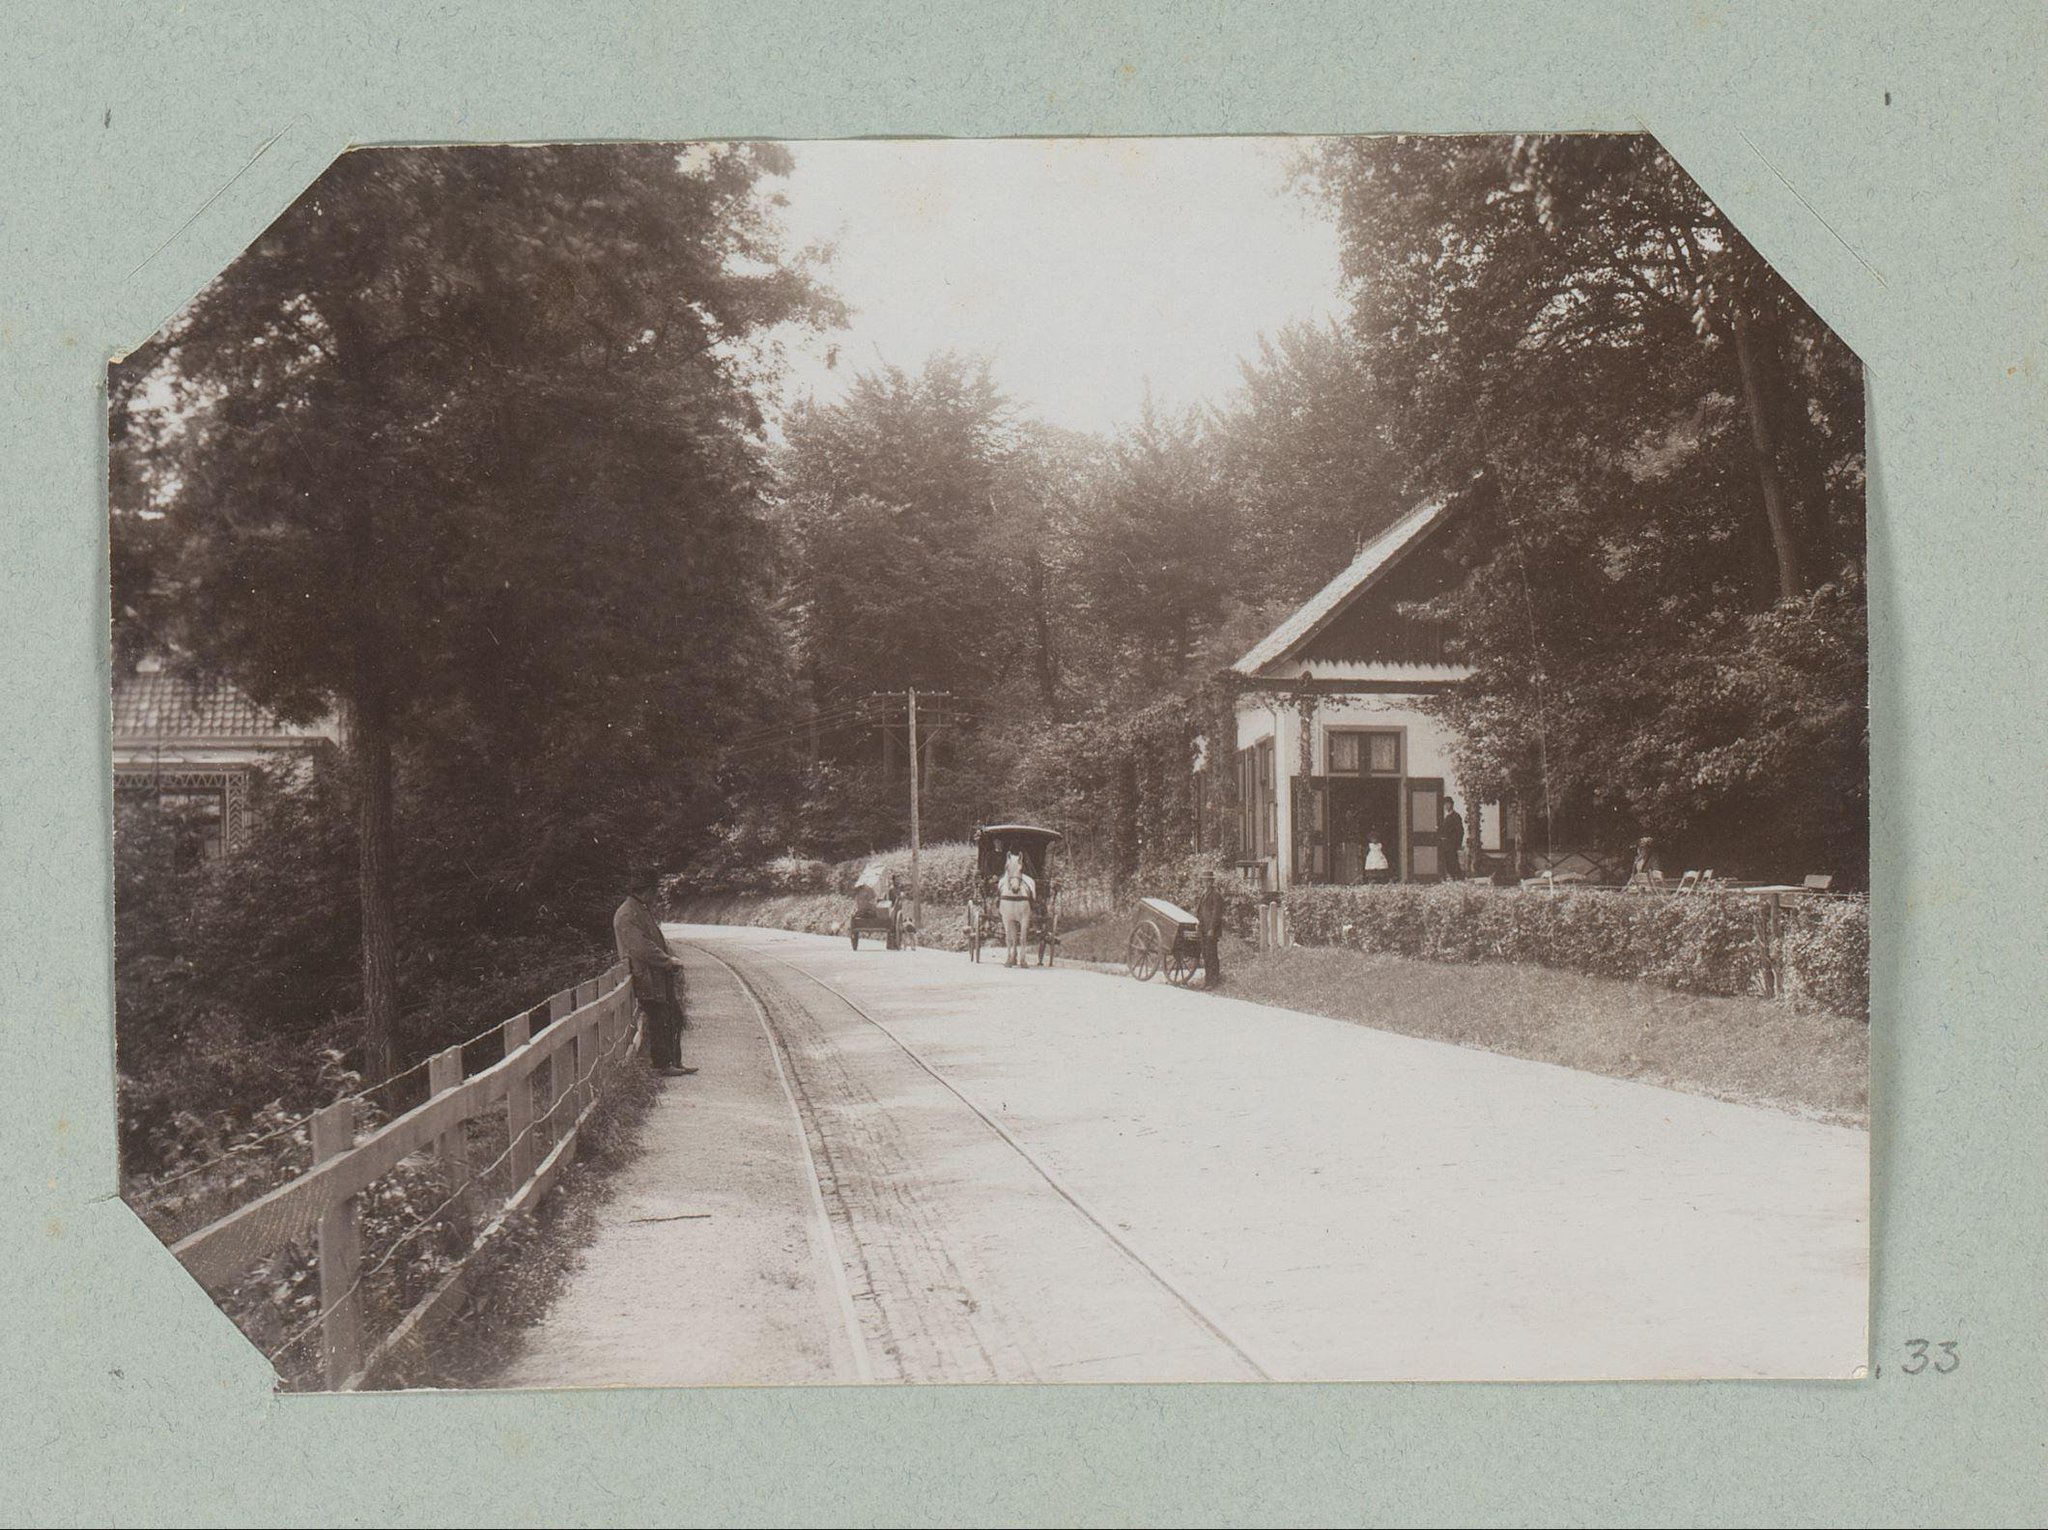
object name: photograph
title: Straat met rijtuig en handkarren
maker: Anonymous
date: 1895-1905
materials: paper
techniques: collodion silver print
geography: netherlands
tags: street, netherlands